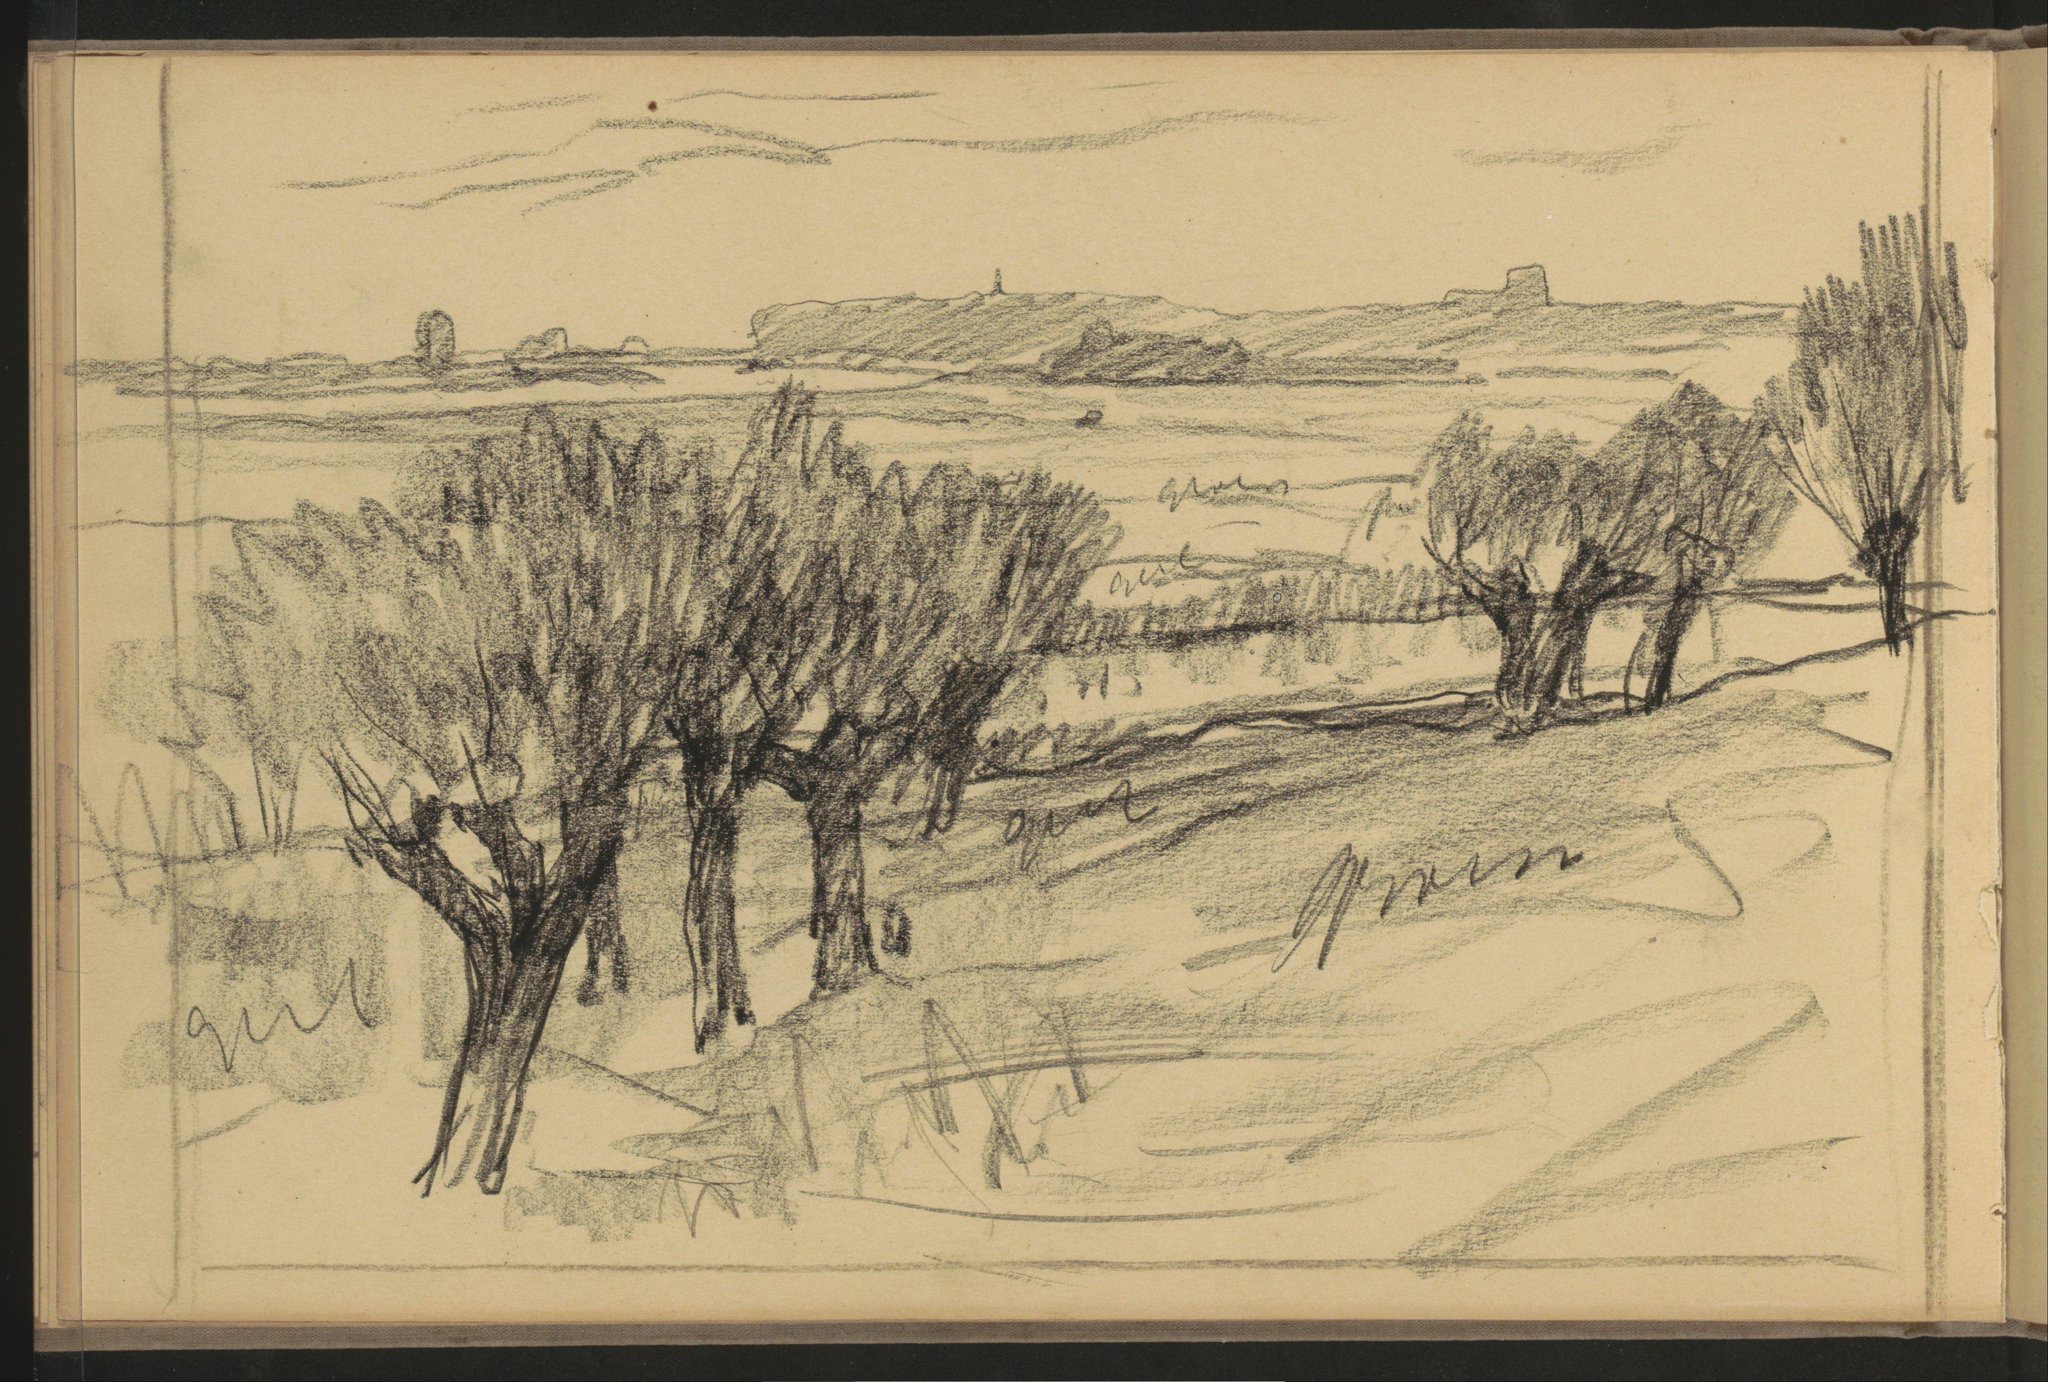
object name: sketchbook leaf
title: Rivierlandschap met een stadsgezicht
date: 1901-1907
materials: chalk, paper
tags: city-view, and landscape with man-made constructions, water course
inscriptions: kleurnotitie, handgeschreven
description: Mogelijk de omgeving van Wijk bij Duurstede. Pagina 82 uit een schetsboek met 60 bladen.